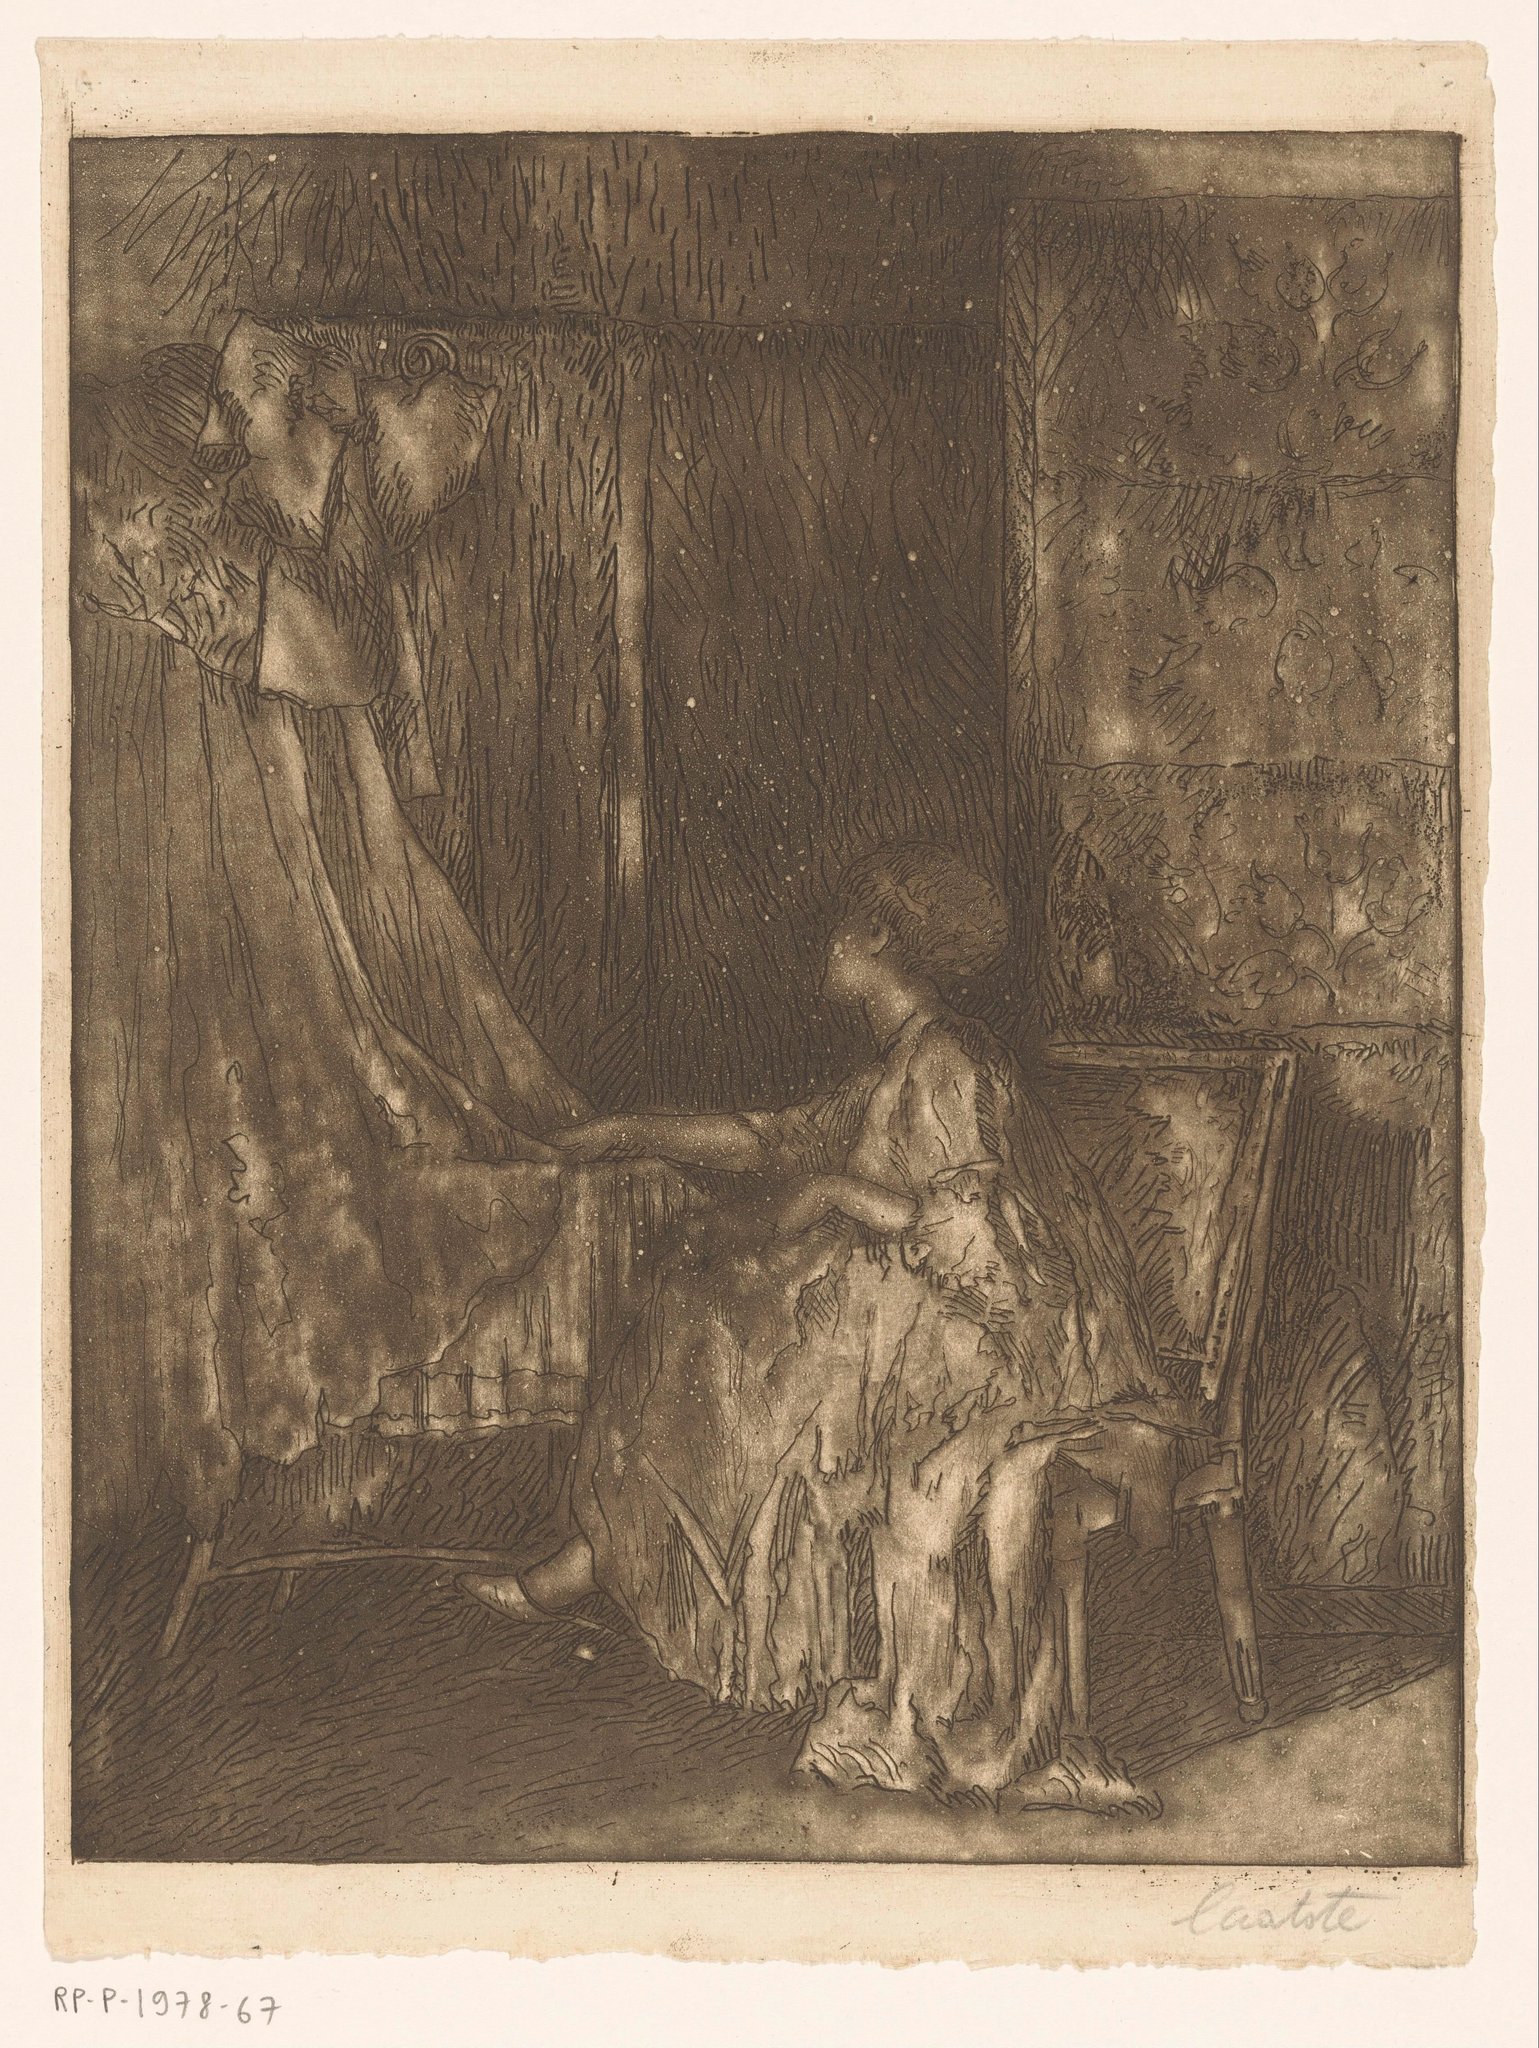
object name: print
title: Vrouw die op een stoel naast een wieg zit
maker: albert roelofs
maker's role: print maker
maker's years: 1877-1920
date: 1887-1920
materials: paper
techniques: aquatint, etching, roulette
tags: cradle, crib, mother and child(ren), woman and child(ren) (family group)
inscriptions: collector's mark: Lugt 2228, collector's mark: Lugt 2760, inscription: ‘laatste’, number: ‘1219 / 21’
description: De vrouw leunt met haar arm op de rand van de wieg.